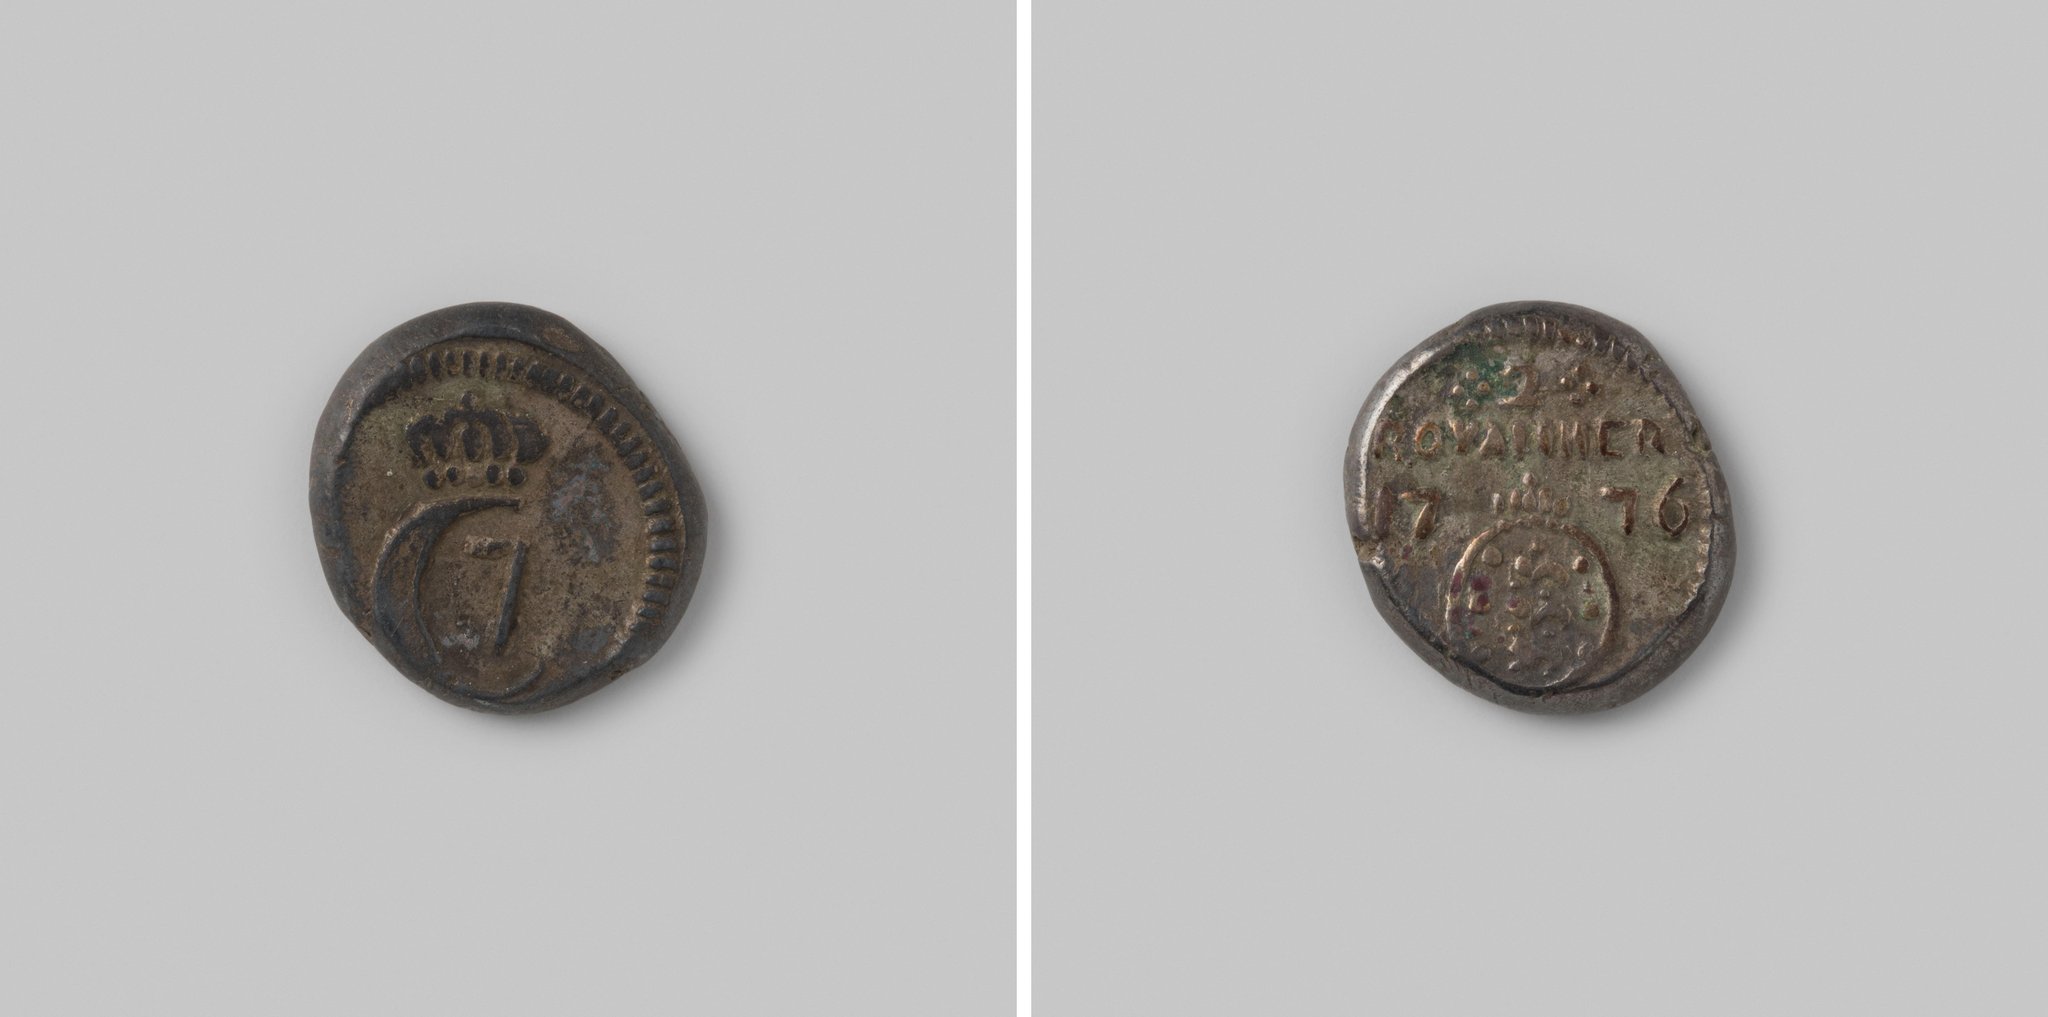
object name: coin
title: Tranquebar, Deens-India, Deense Aziatische Compagnie (DAC) op naam van koning Frederik VII, 2 royaliner, 1776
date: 1776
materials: silver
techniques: striking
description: Zilveren munt. Voorzijde: gekroond monogram van de koning. Keerzijde: waarde-aanduiding: 2 royaliner in twee regels. Daaronder tussen jaartal gekroond ovaal Deens wapenschild.